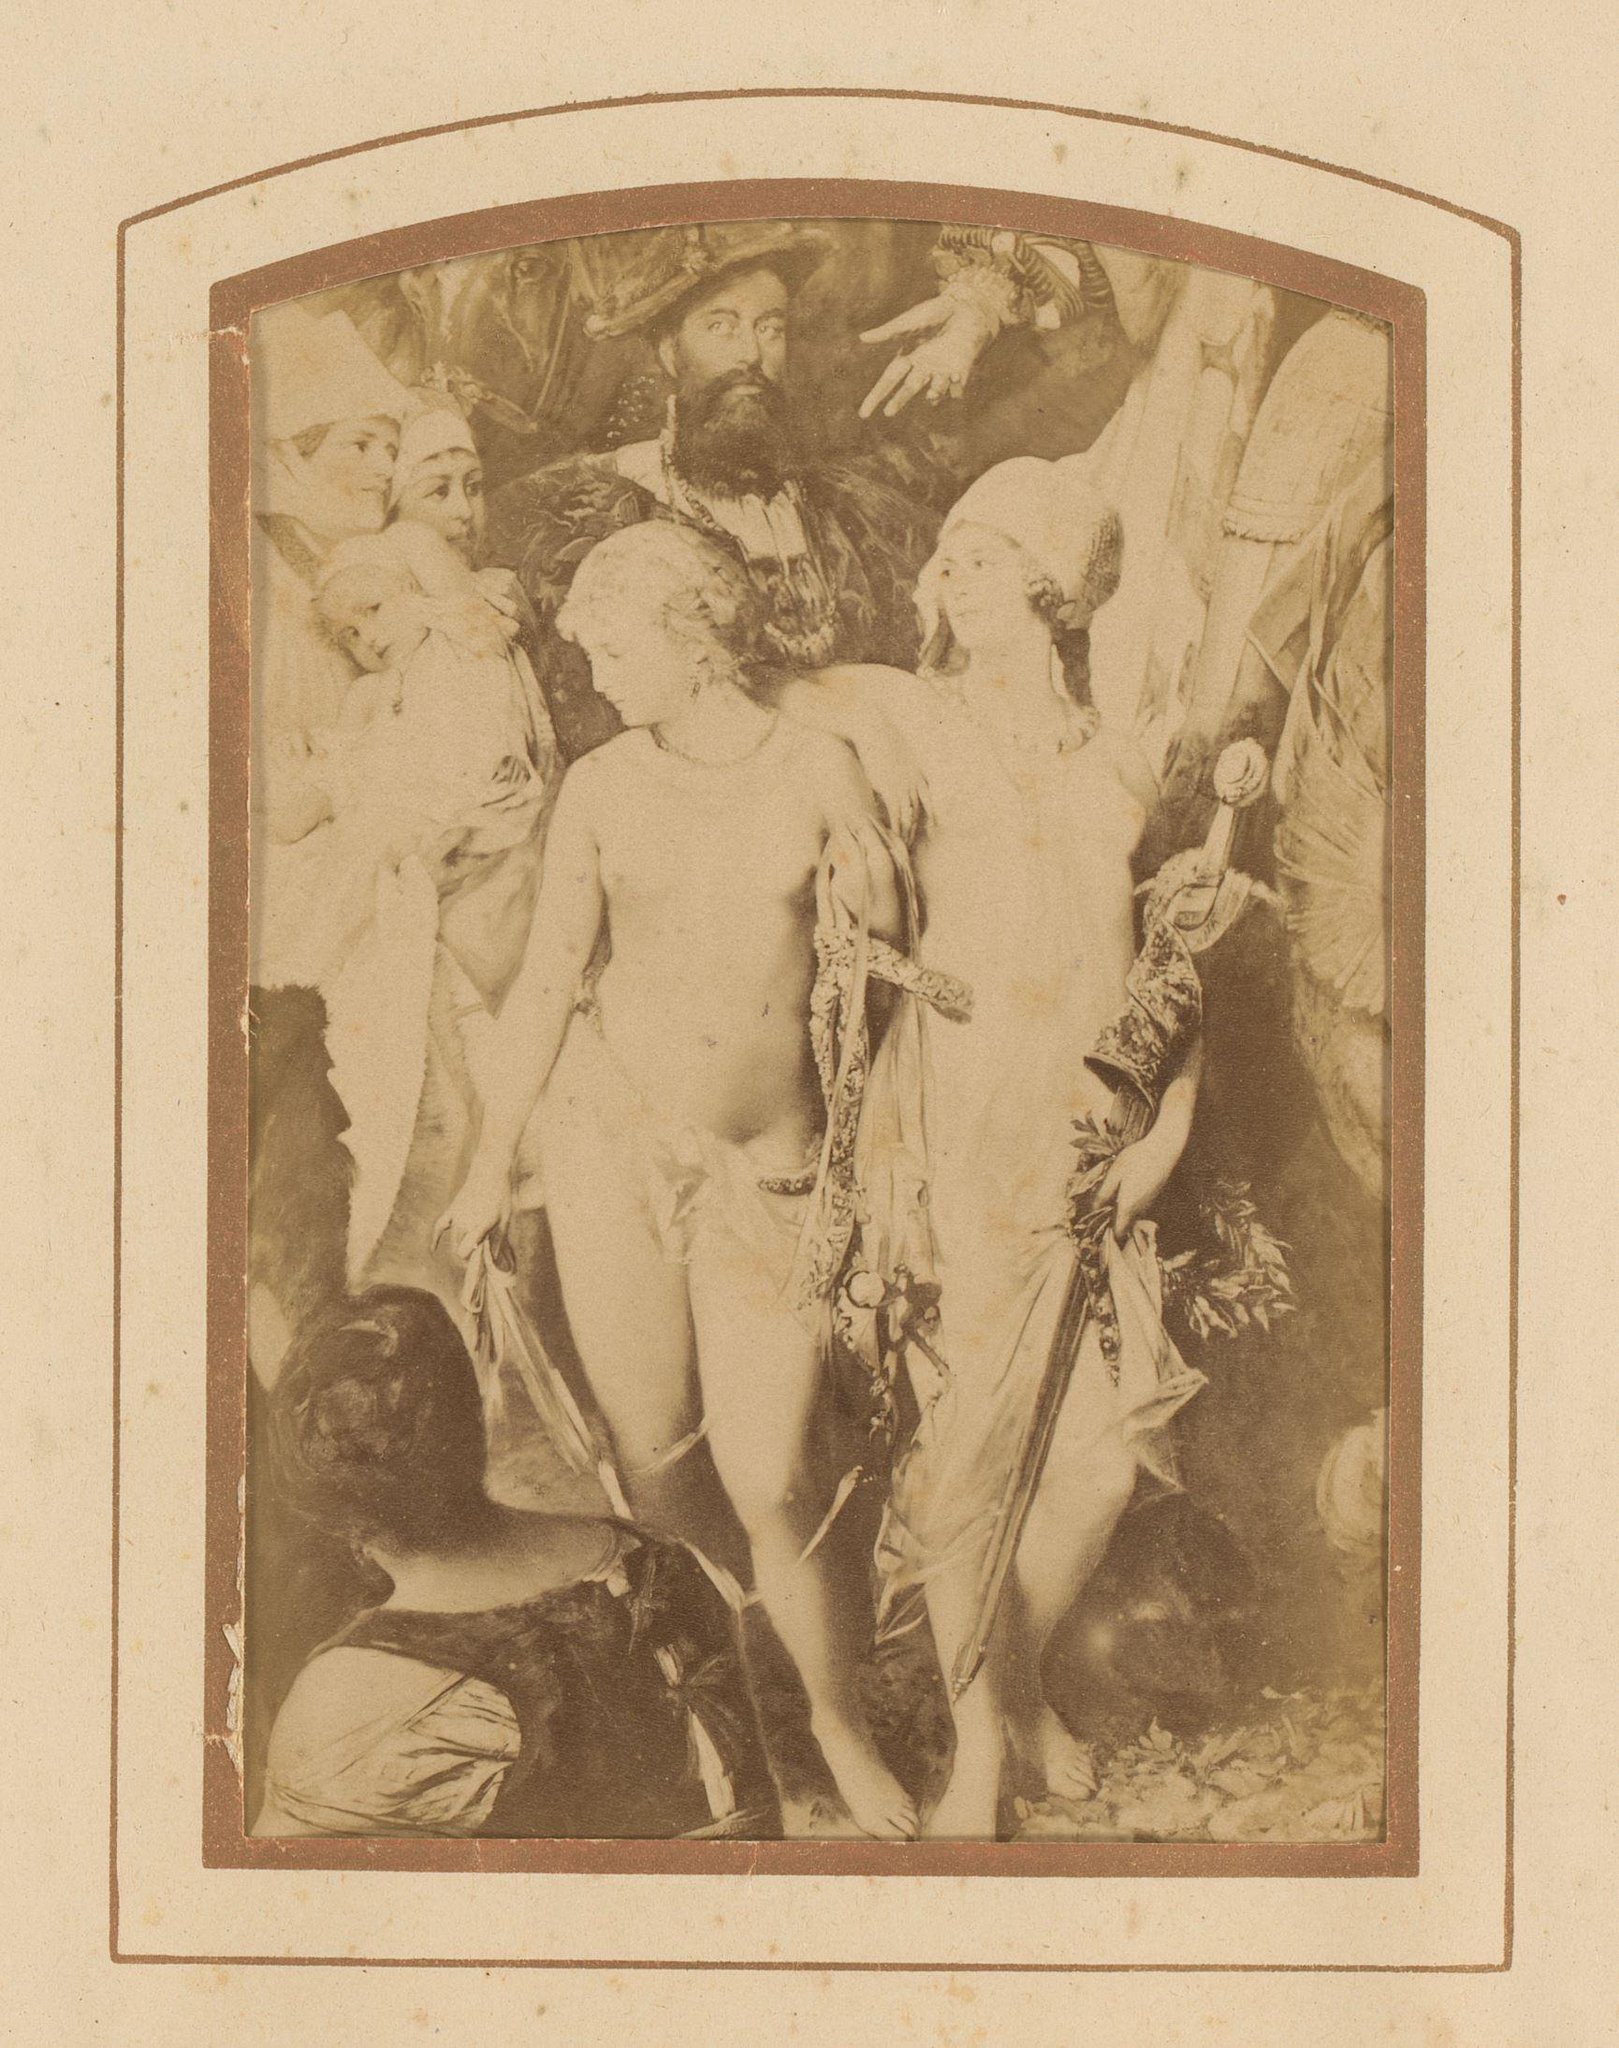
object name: reproduction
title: Fotoreproductie van een deel van een schilderij van de aankomst van Karel V in Antwerpen door Hans Makart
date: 1878-1900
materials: cardboard, photographic support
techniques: albumen print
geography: vienna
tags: woman (showing herself) undressed, quasi-nude, being welcomed ~ travelling, ruler, sovereign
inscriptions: inscription: ‘VERVIELFÄLTIGUNG VORBHELATEN. 254. DEPOSÉ. REGISTERED.’